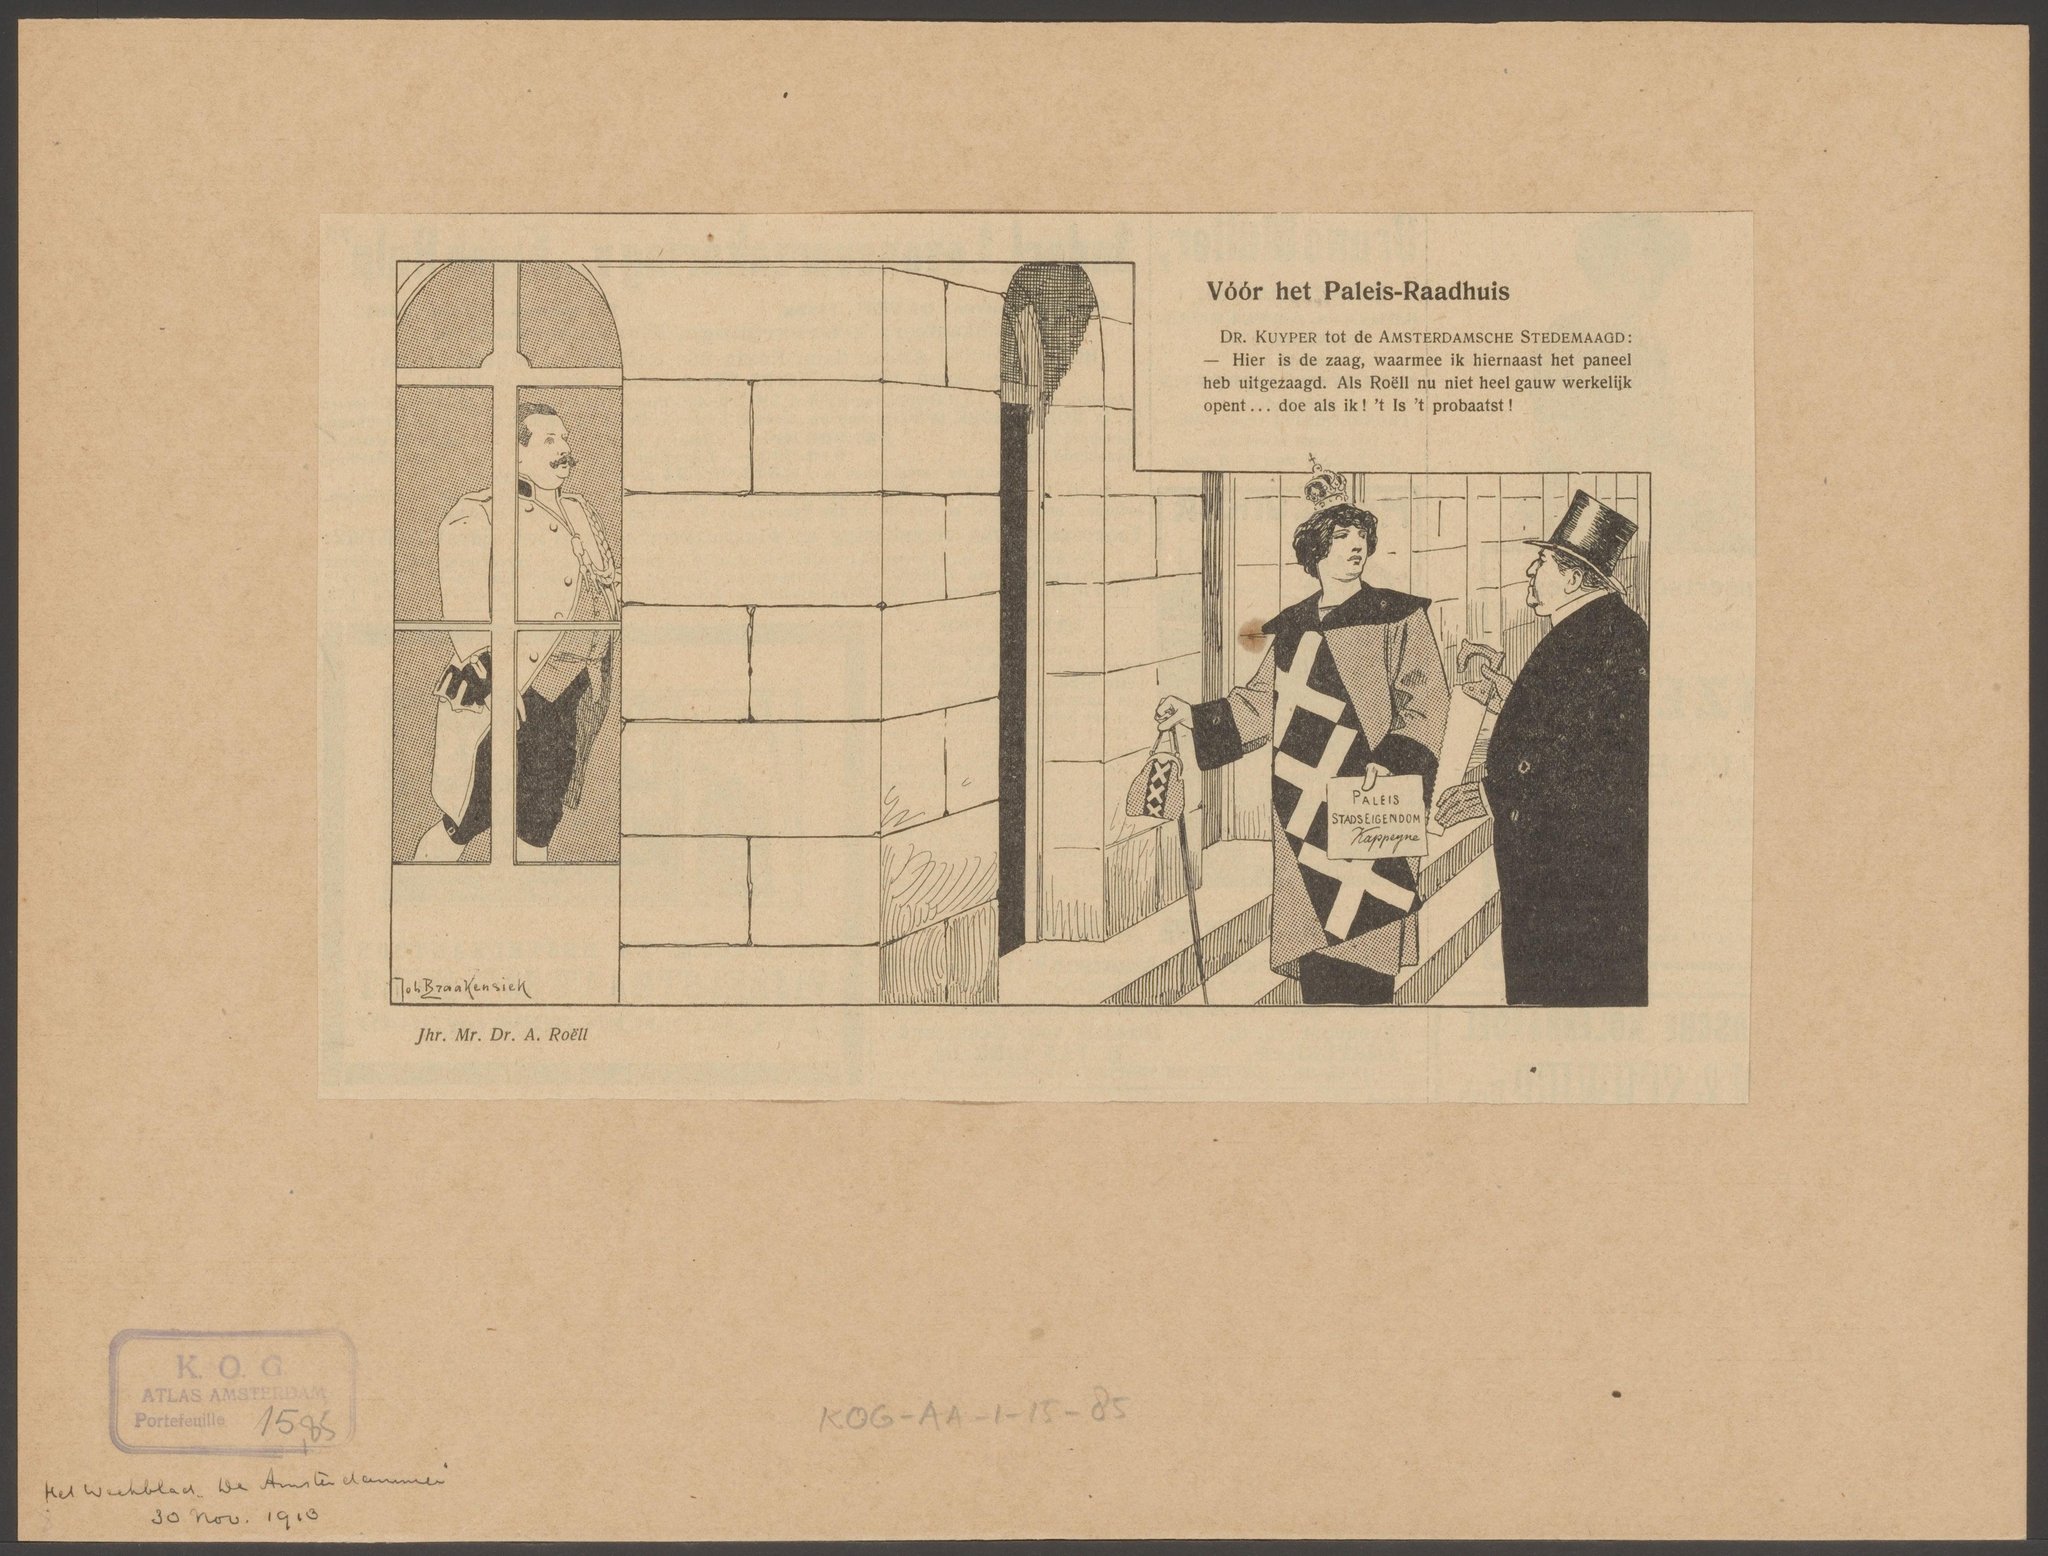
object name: cartoon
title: Spotprent over de Paleis-Raadhuiskwestie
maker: johan braakensiek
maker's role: draughtsman, print maker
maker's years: 1858-1940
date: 1913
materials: paper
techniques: letterpress printing, line block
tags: city-view in general; 'veduta', palace, townhall, royal palace of amsterdam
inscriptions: collector's mark: ‘15,85’ Lugt 1641b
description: Onderwerpsrubriek binnen de Atlas Amsterdam: Nieuwe Stadhuis op de Dam, van buiten, Kleine steentjes kwestie, Paleis - Raadhuiskwestie.